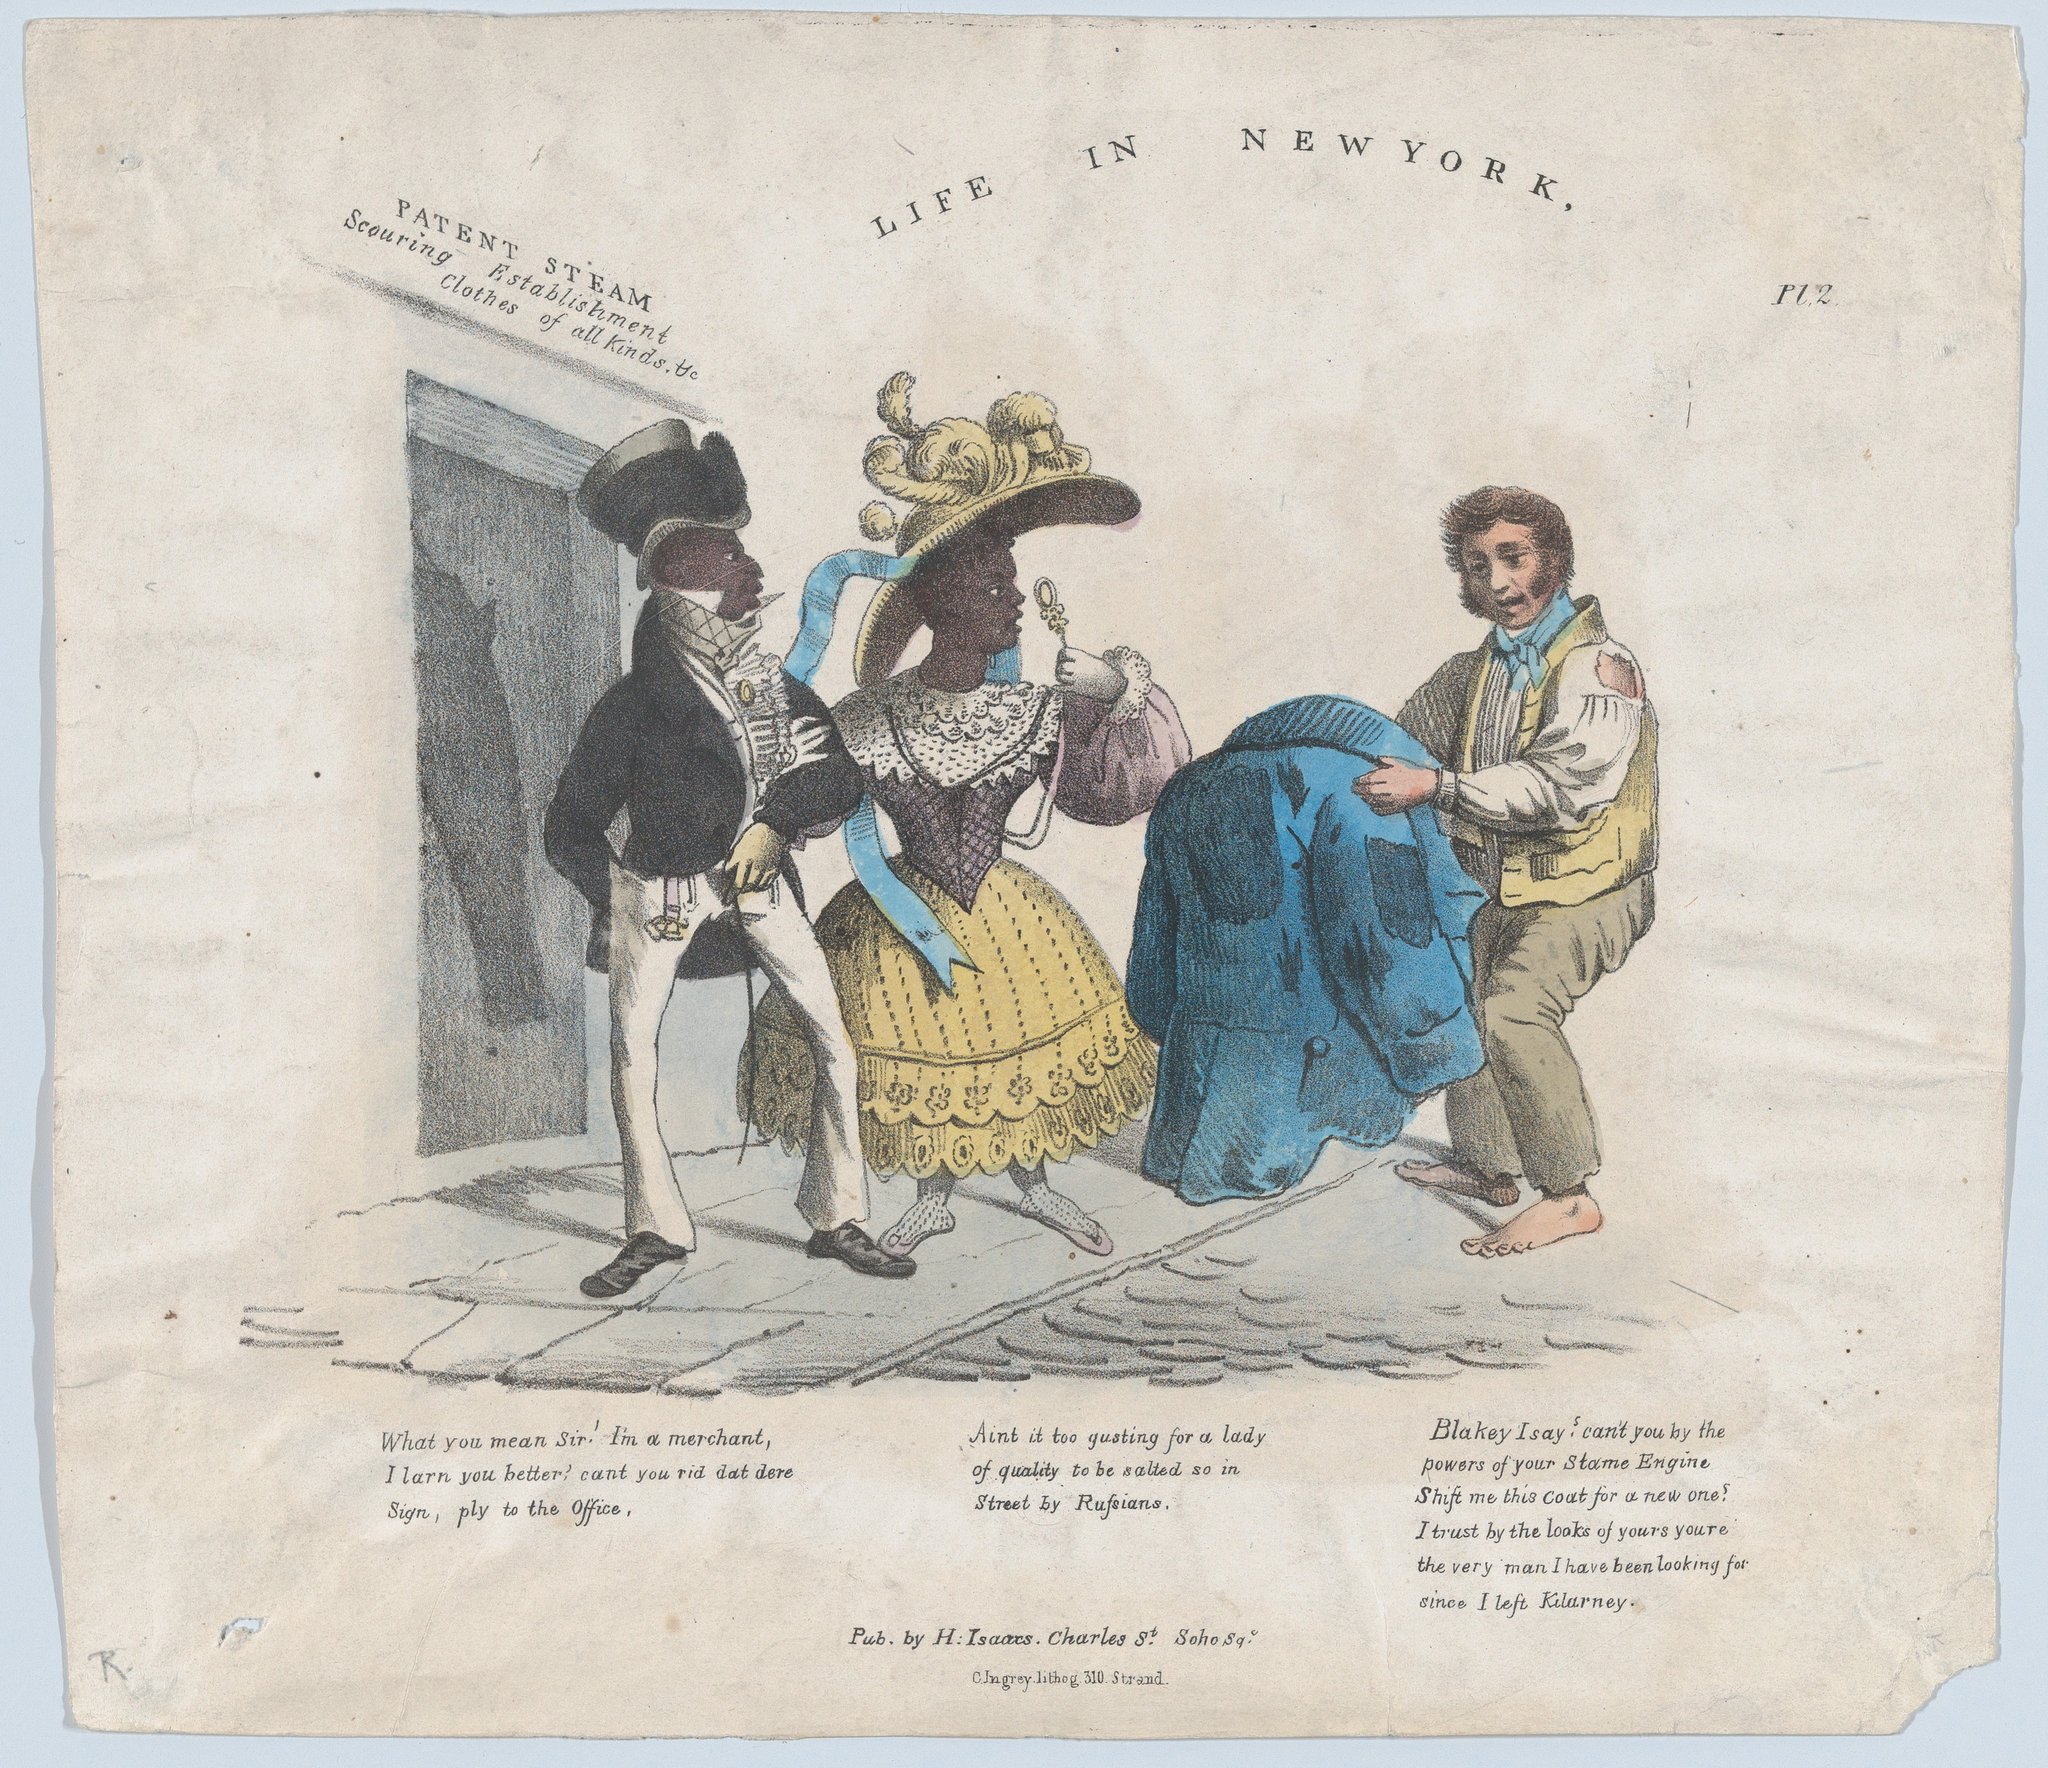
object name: print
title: Life in New York. Blakey, I say, can't you by the powers of your Stame Engine...?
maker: harrison isaacs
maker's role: publisher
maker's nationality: british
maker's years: 1831-1832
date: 1831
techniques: hand coloring, lithograph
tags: men,women